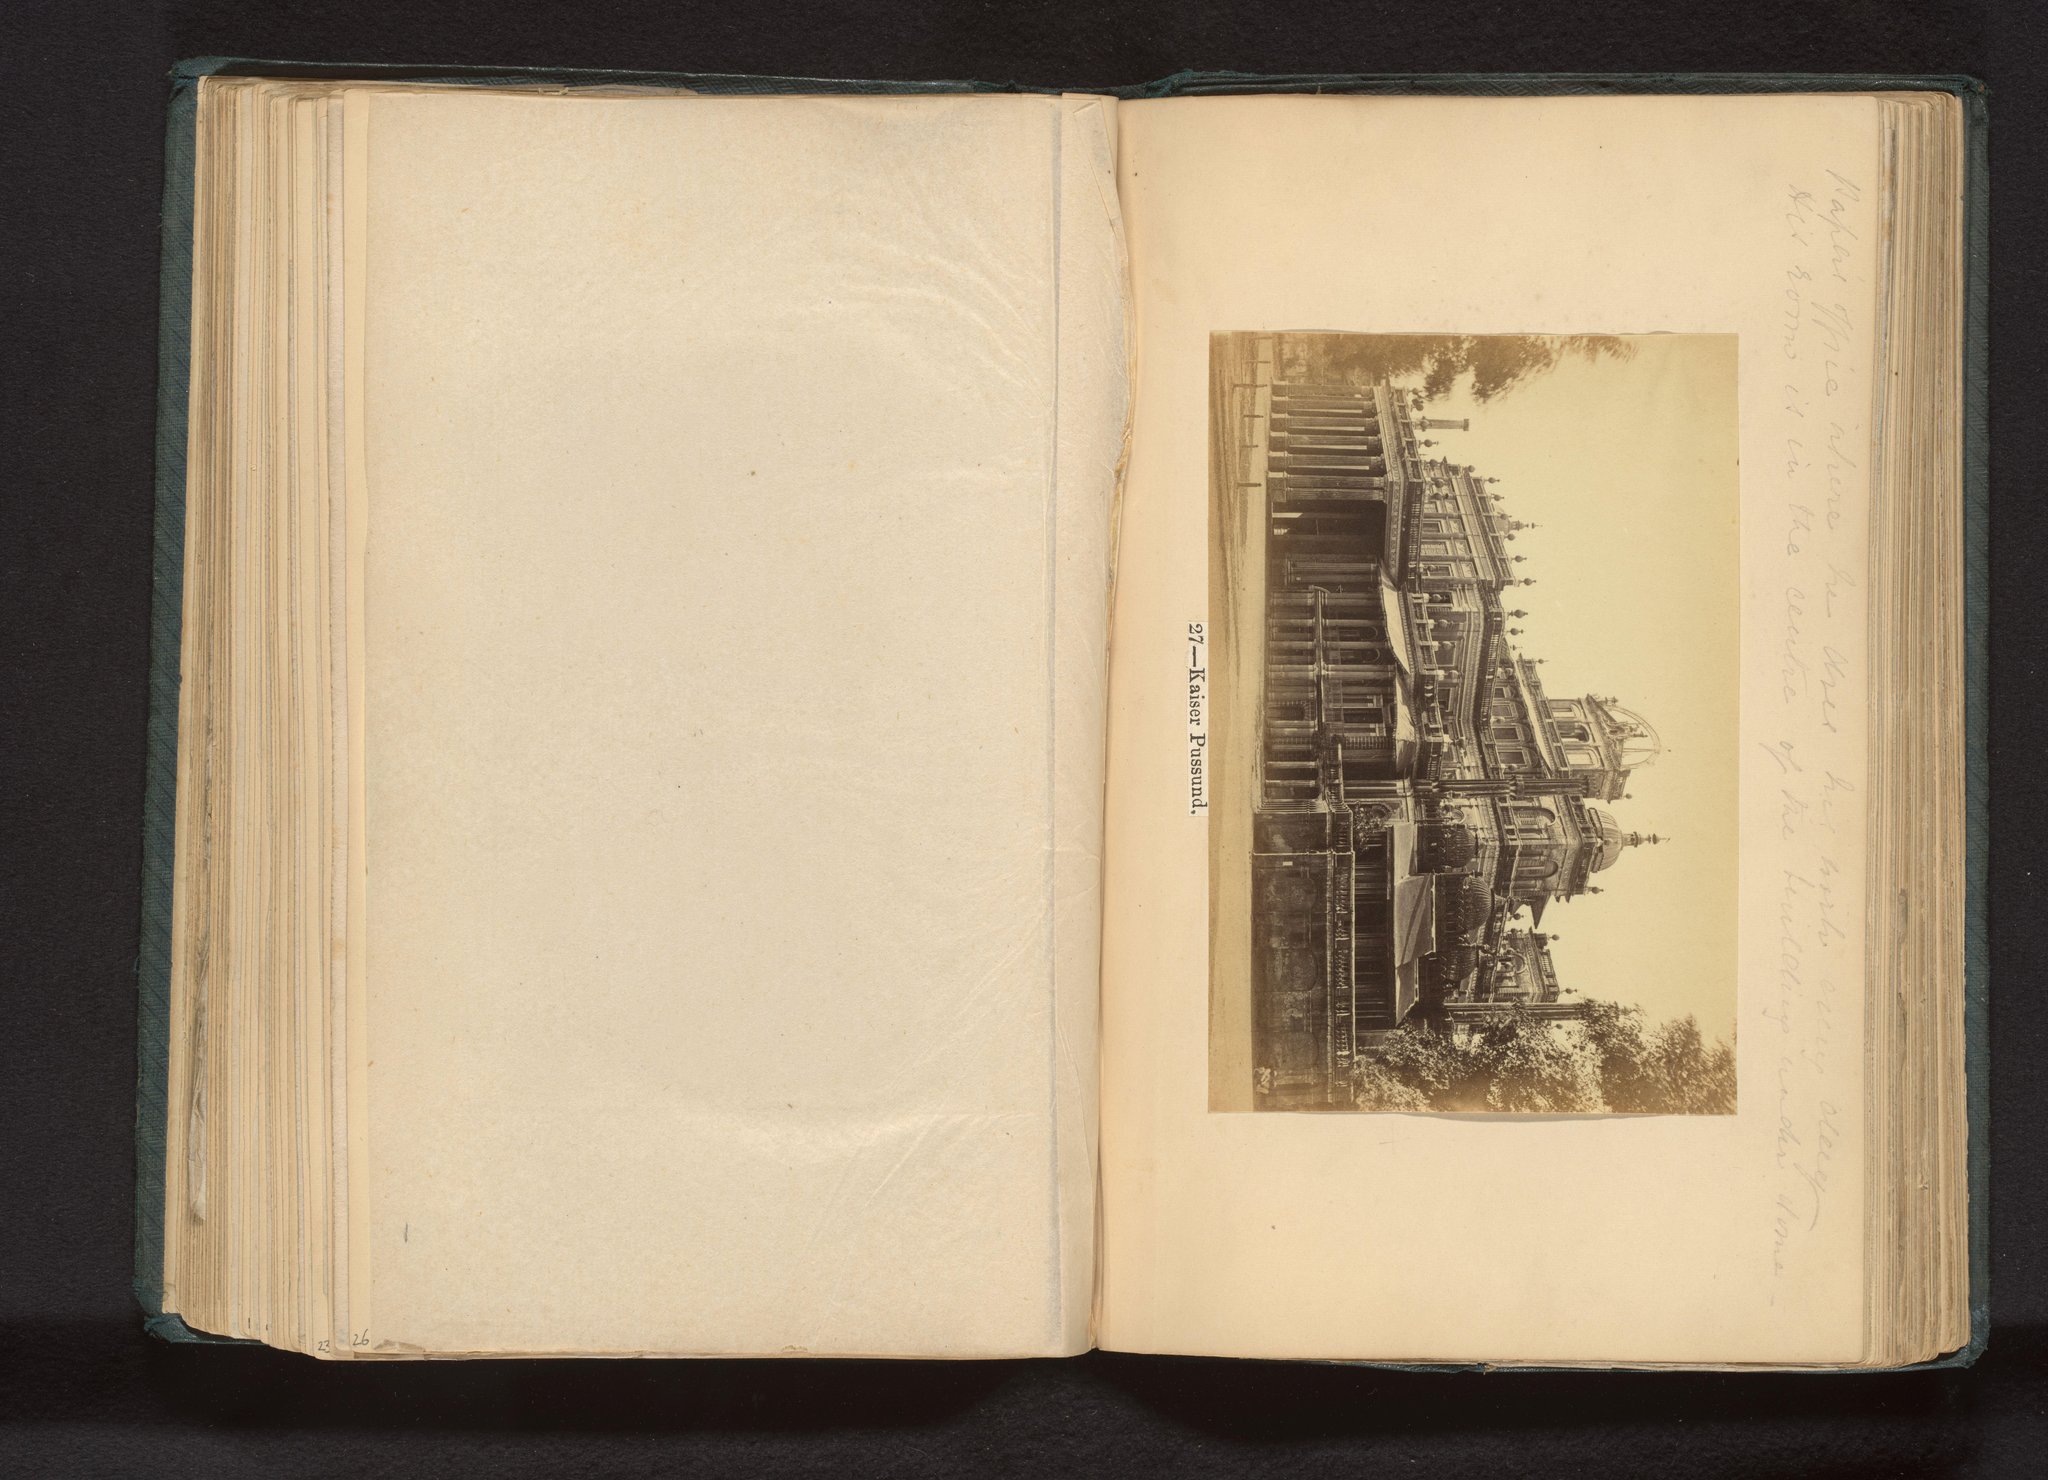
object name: photograph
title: Kaiser Pussund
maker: darogha ubbas alli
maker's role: fotograaf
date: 1864-1874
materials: photographic support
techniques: albumen print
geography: lucknow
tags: housing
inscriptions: number: ‘27’, inscription: ‘Papa's office inhere he [...] his work every day. His [...] it in the centre of the building [...] dome.’